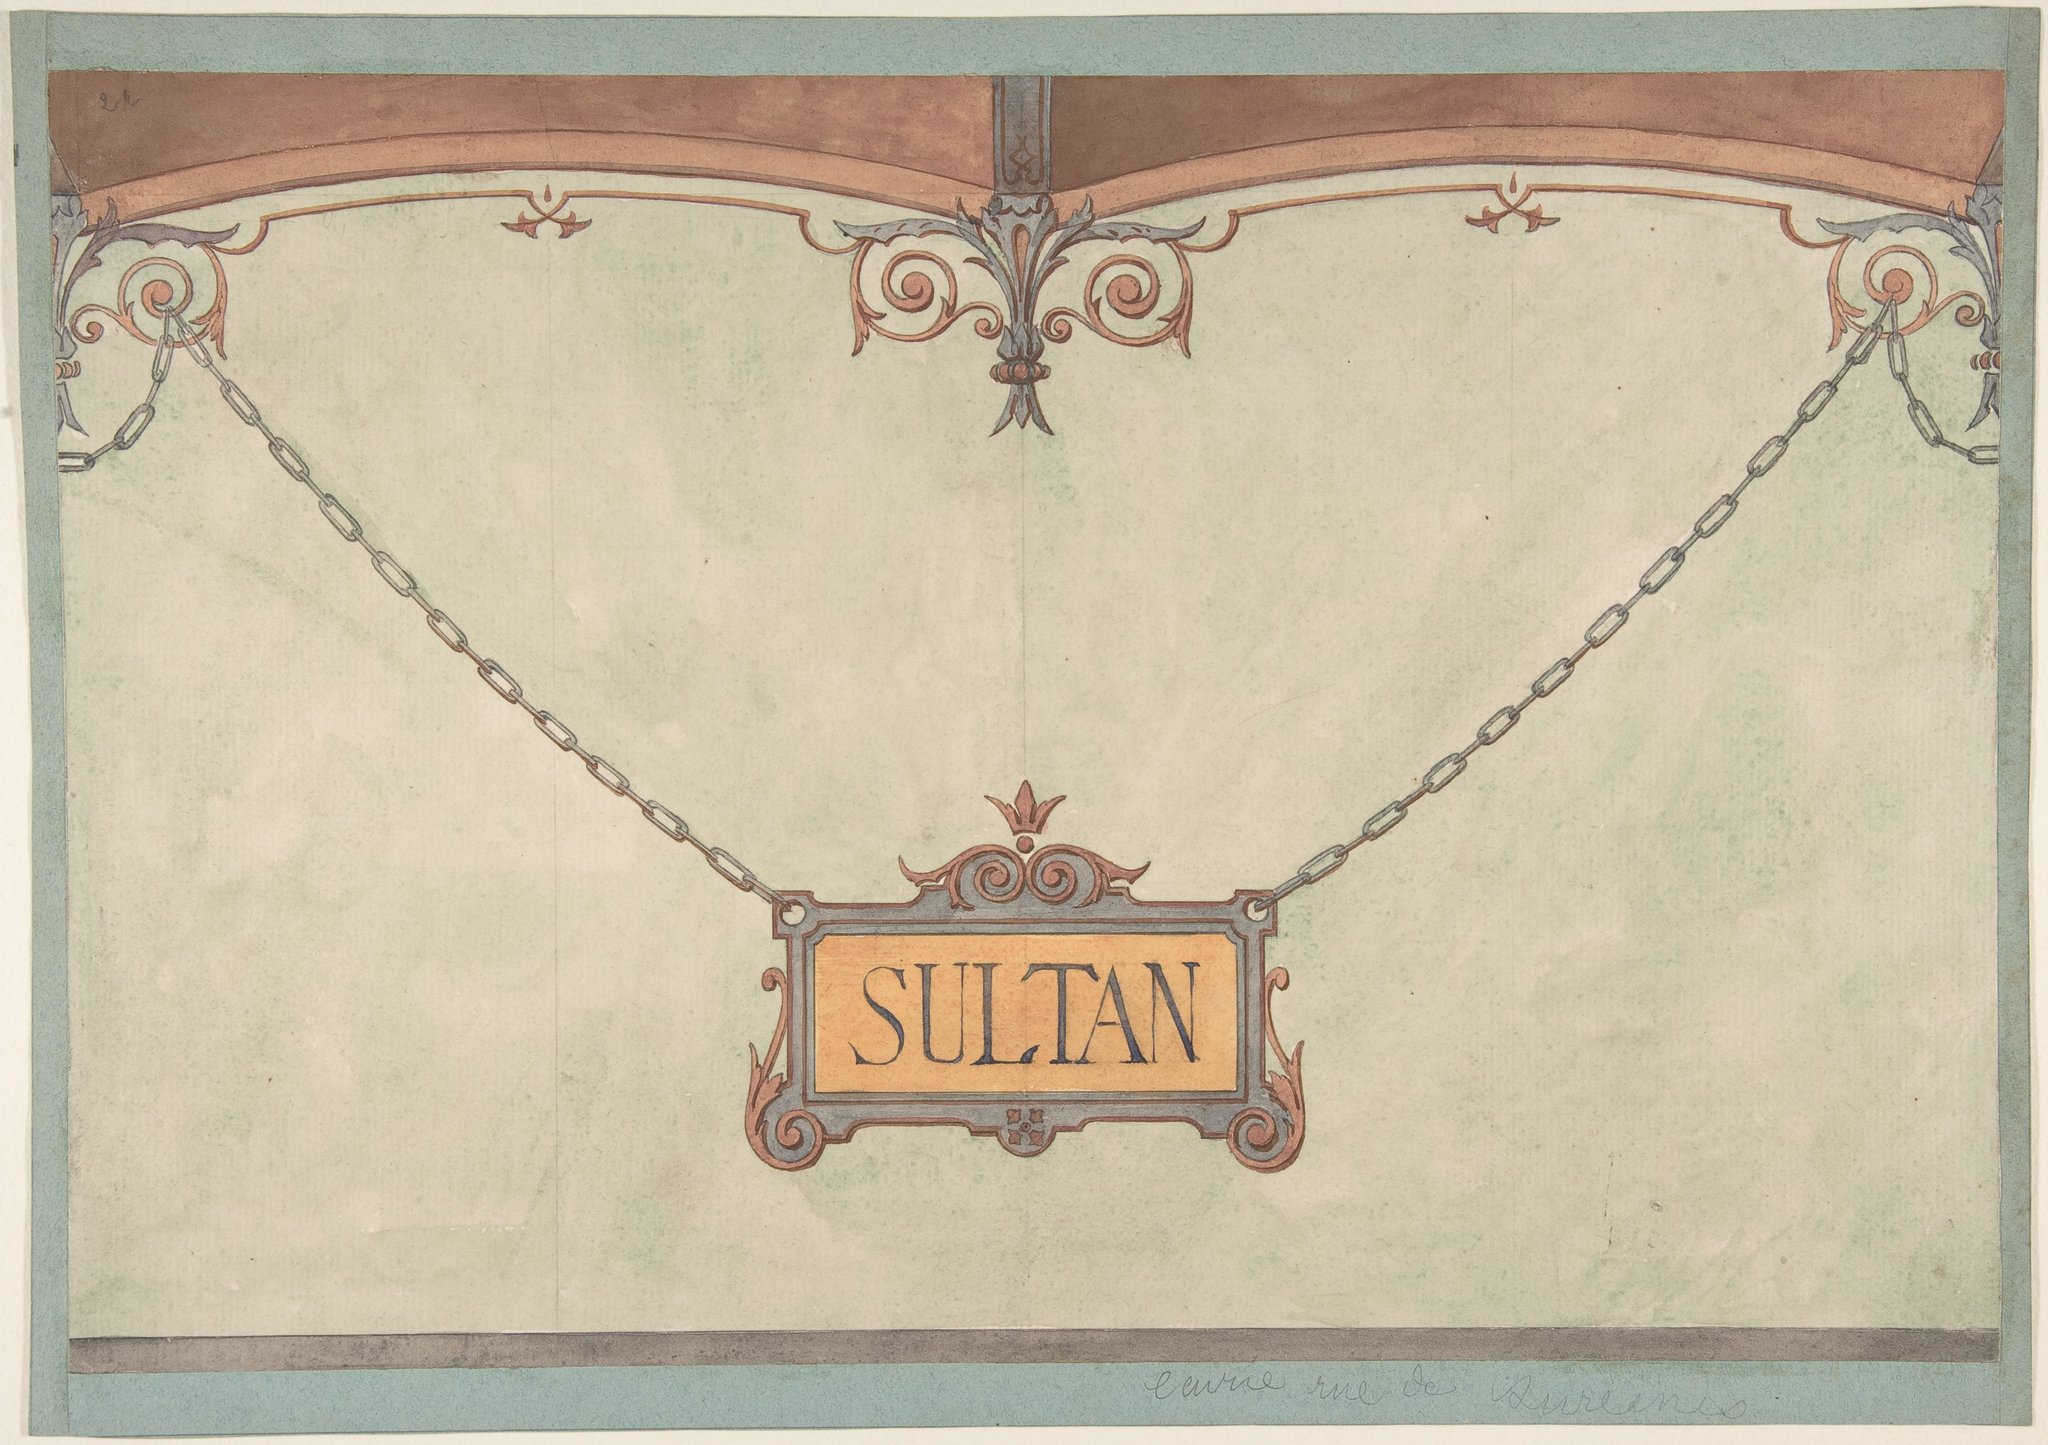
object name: drawing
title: Design for Decorated "Sultan" Plaque for Stable Wall, Hôtel Candamo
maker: jules-edmond-charles lachaise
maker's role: artist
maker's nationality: french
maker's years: 1897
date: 1873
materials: ink, watercolor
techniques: pen